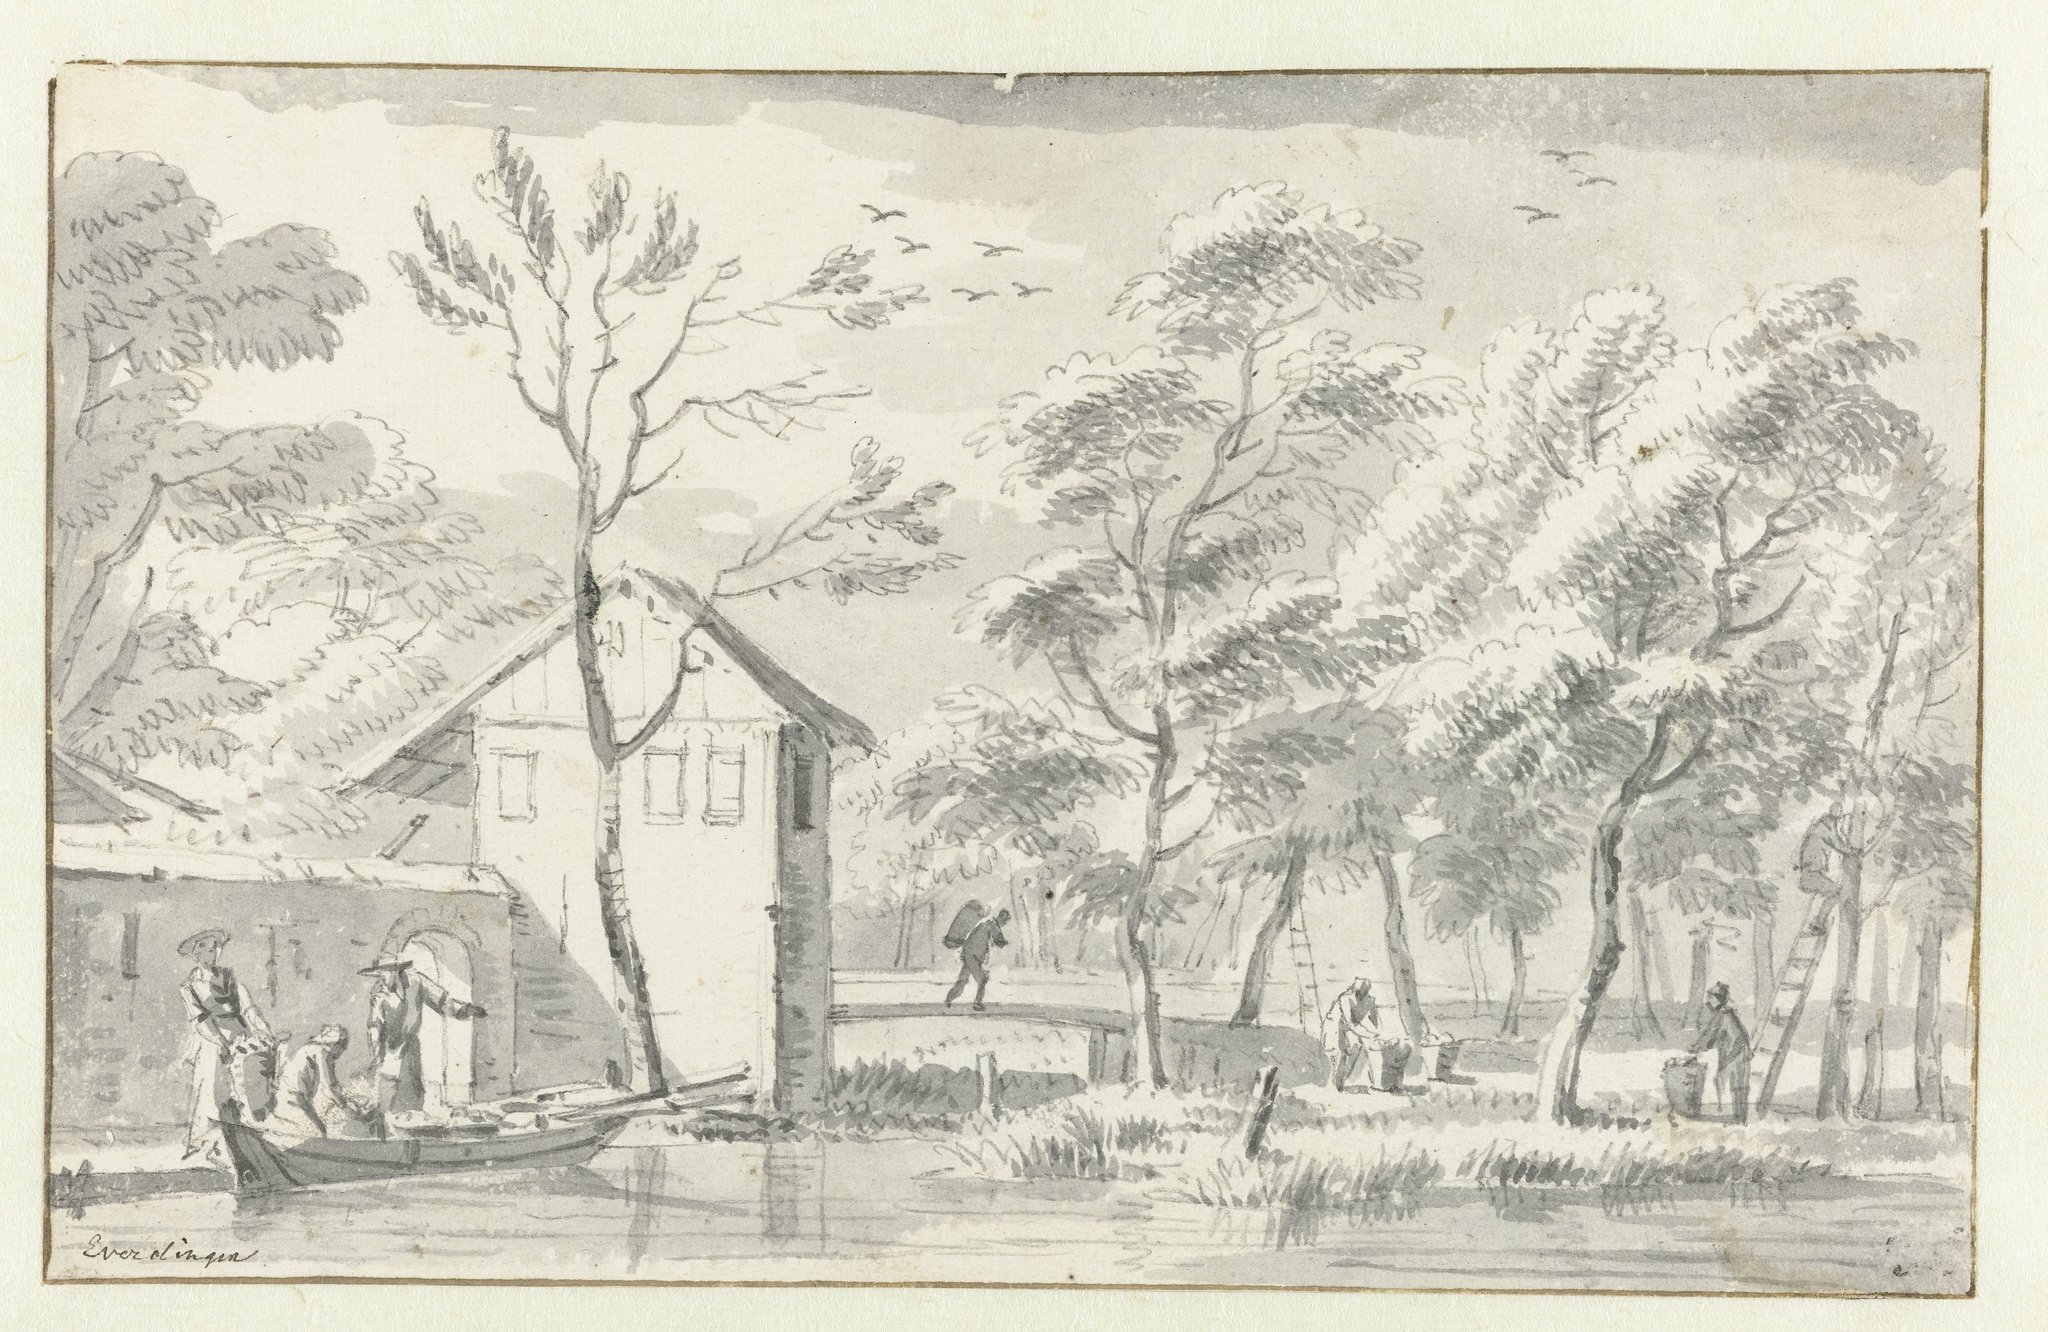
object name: drawing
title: De vruchtenoogst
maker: allaert van everdingen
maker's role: draughtsman, painter, print maker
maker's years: 1621-1675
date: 1631-1675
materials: graphite, paper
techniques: brush